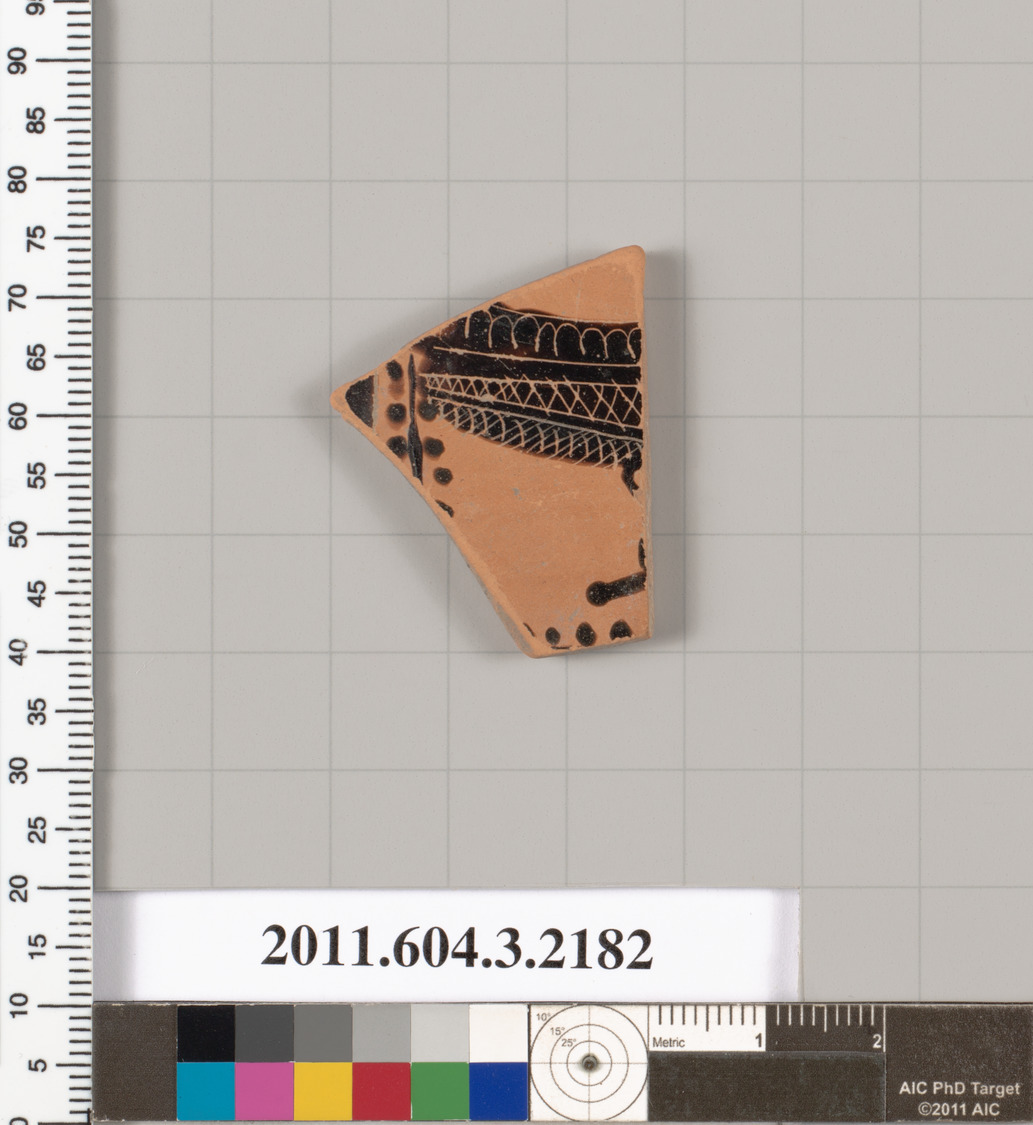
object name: kylix fragment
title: Terracotta fragment of a kylix (drinking cup)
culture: greek, attic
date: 525-501 BCE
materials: terracotta